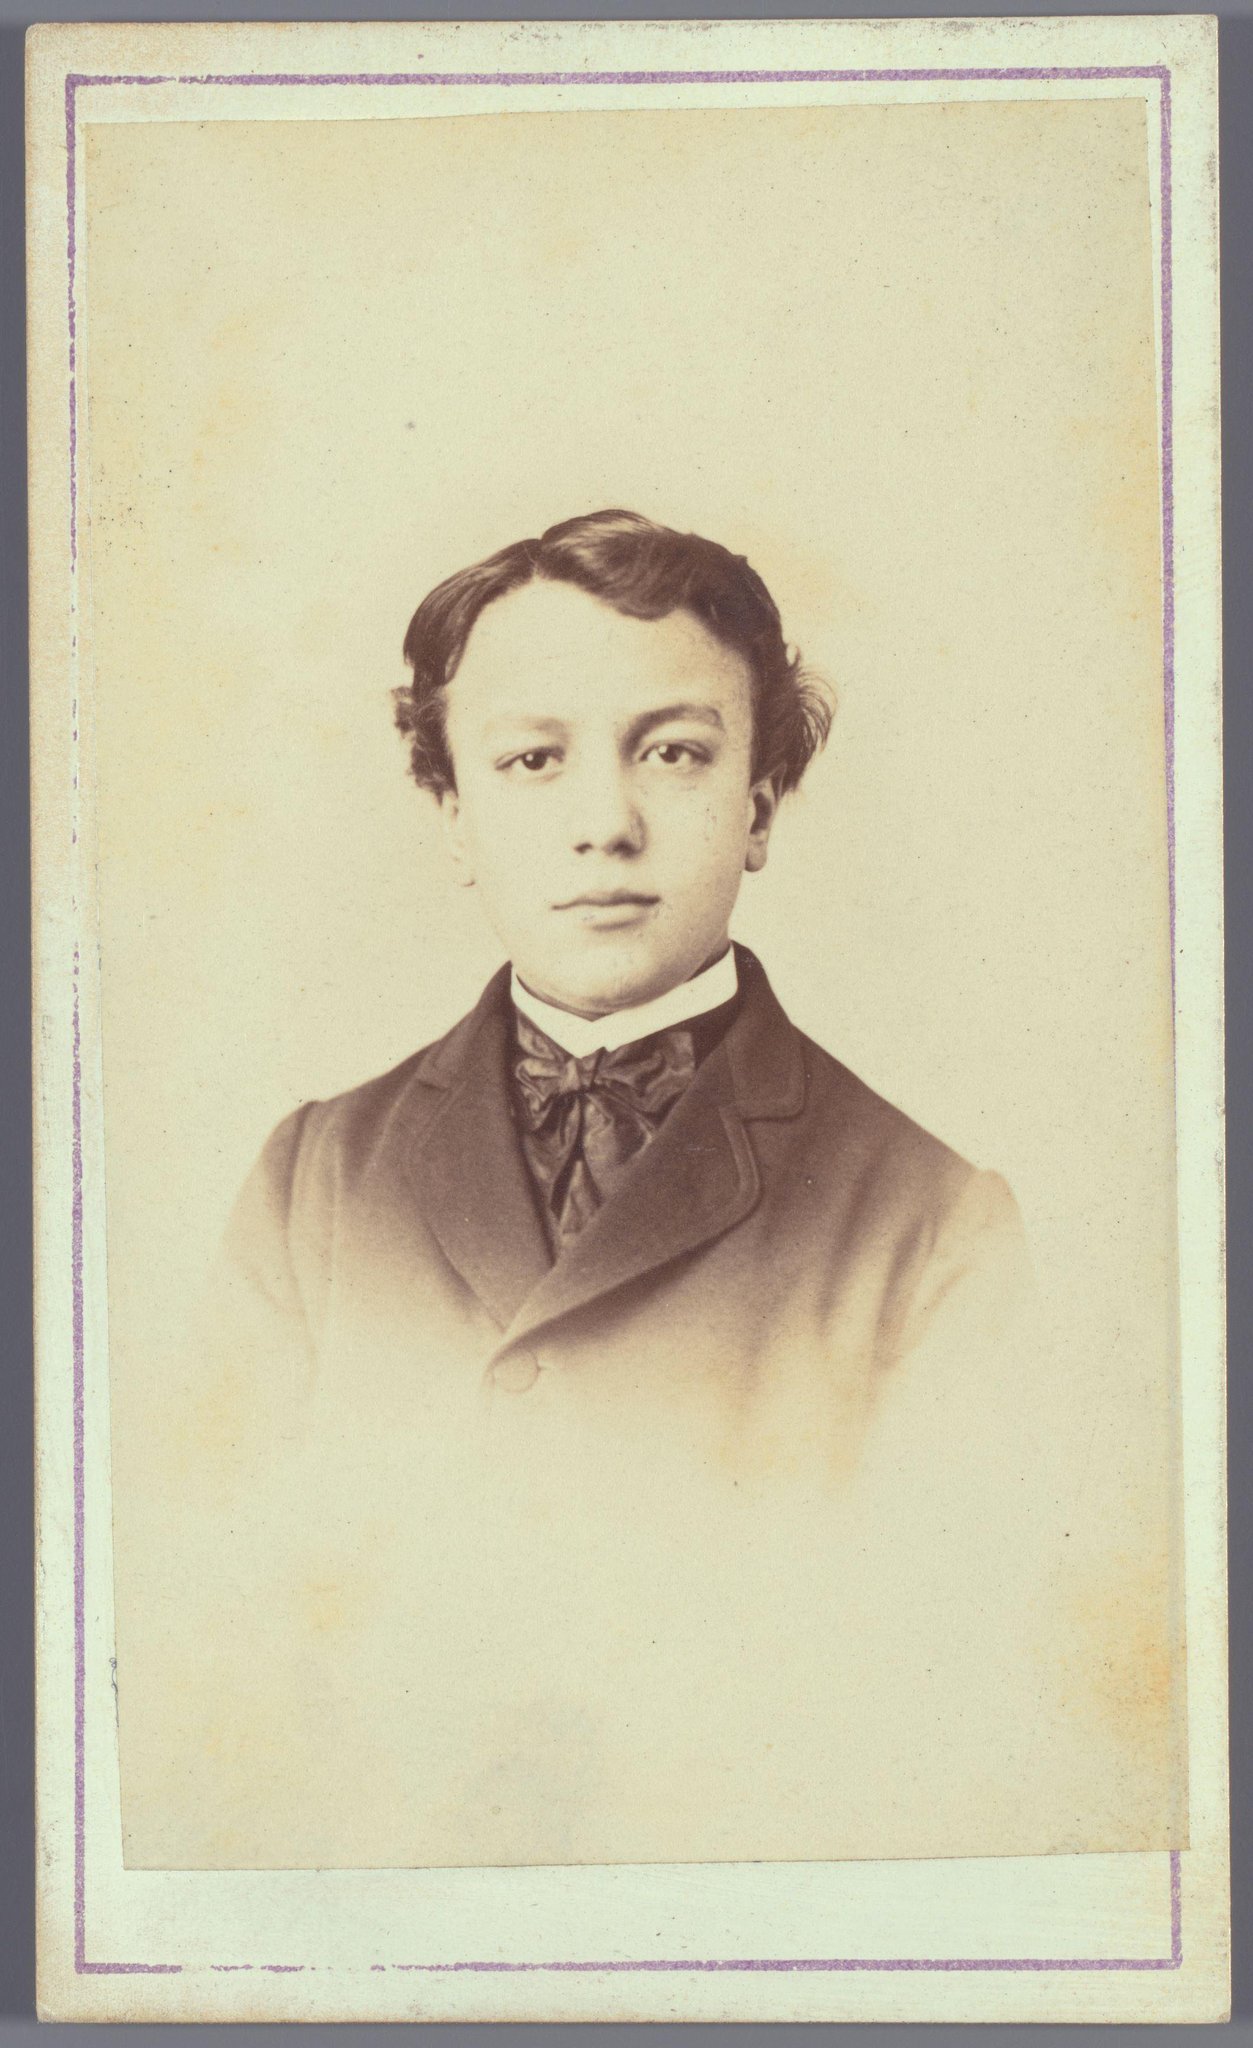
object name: carte de visite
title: Portret van een onbekende jongen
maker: e. cornelisse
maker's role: fotograaf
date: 1863-1875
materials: cardboard, paper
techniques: albumen print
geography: brussels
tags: boy (child between toddler and youth), anonymous historical person portrayed, rotterdam, brussels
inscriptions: inscription: ‘2€/ 22 Demanck.’, inscription: ‘Cornelisse/ Bruxelles, Rue de l'Ecuyer, 38./ Rotterdam, Wagestraat./ English spoken.’